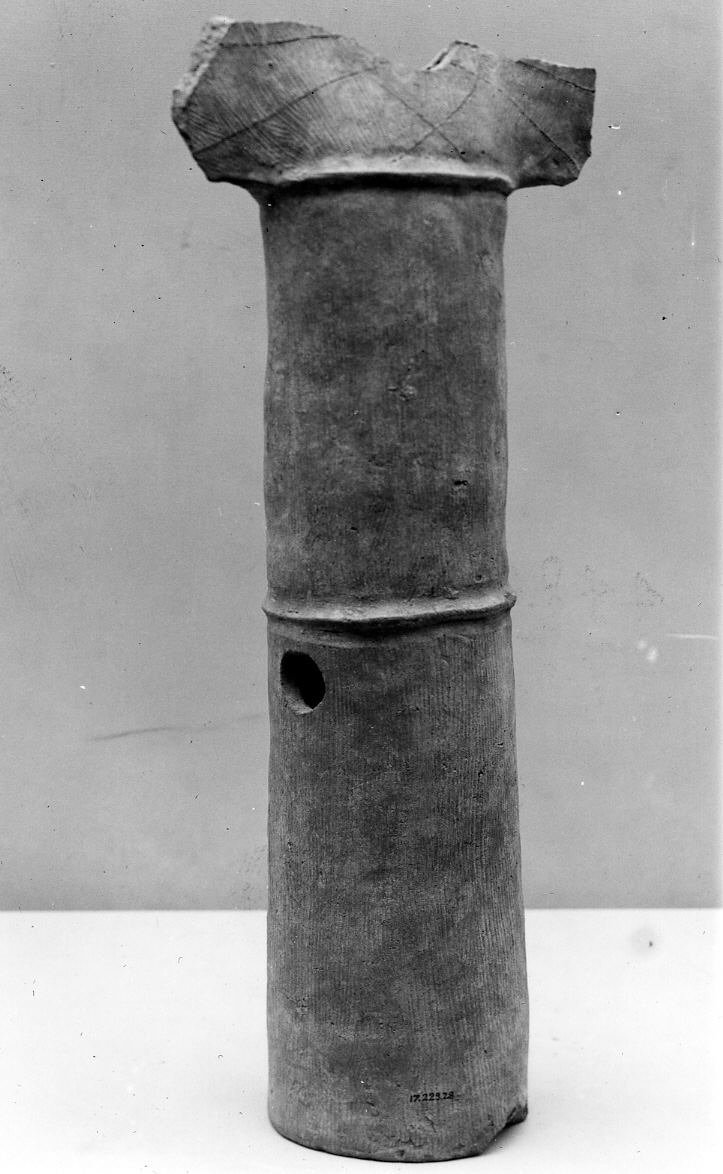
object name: haniwa post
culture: japanese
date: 201-600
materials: earthenware